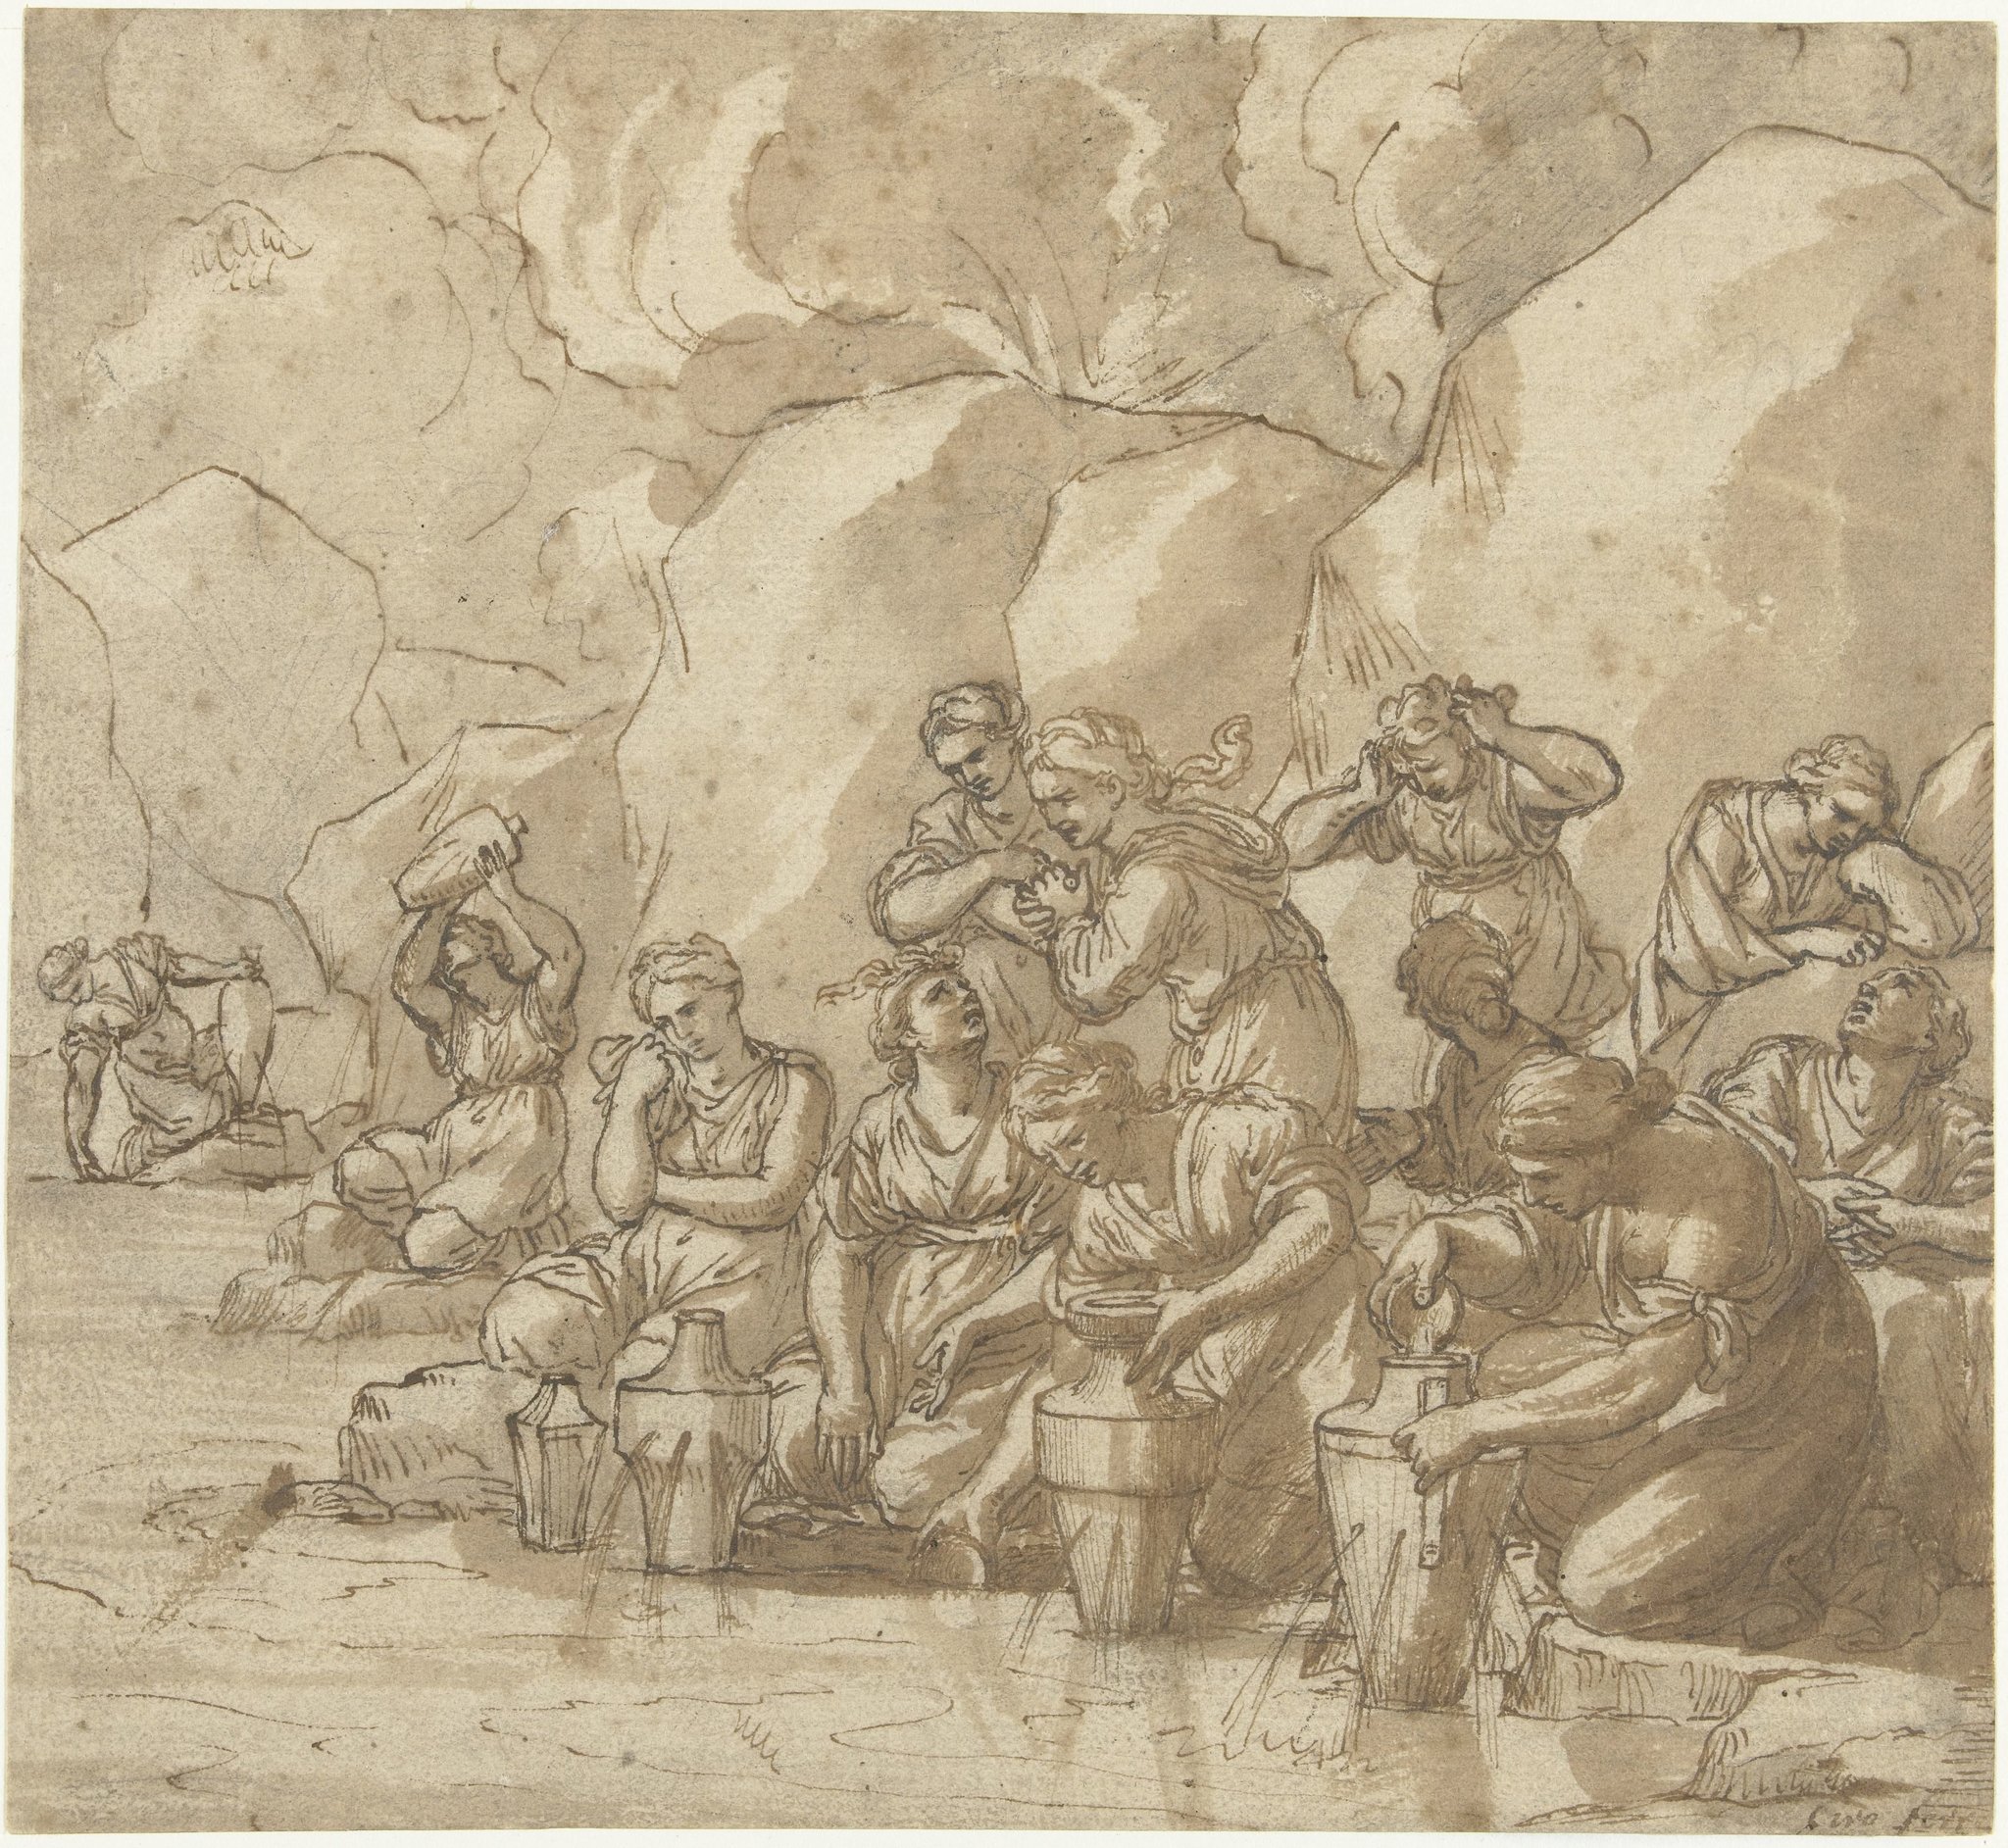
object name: drawing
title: De Danaïden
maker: ciro ferri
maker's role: draughtsman, print maker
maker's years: 1634-1689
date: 1644-1689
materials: chalk, ink, paper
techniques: brush, pen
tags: (story of) the danaids